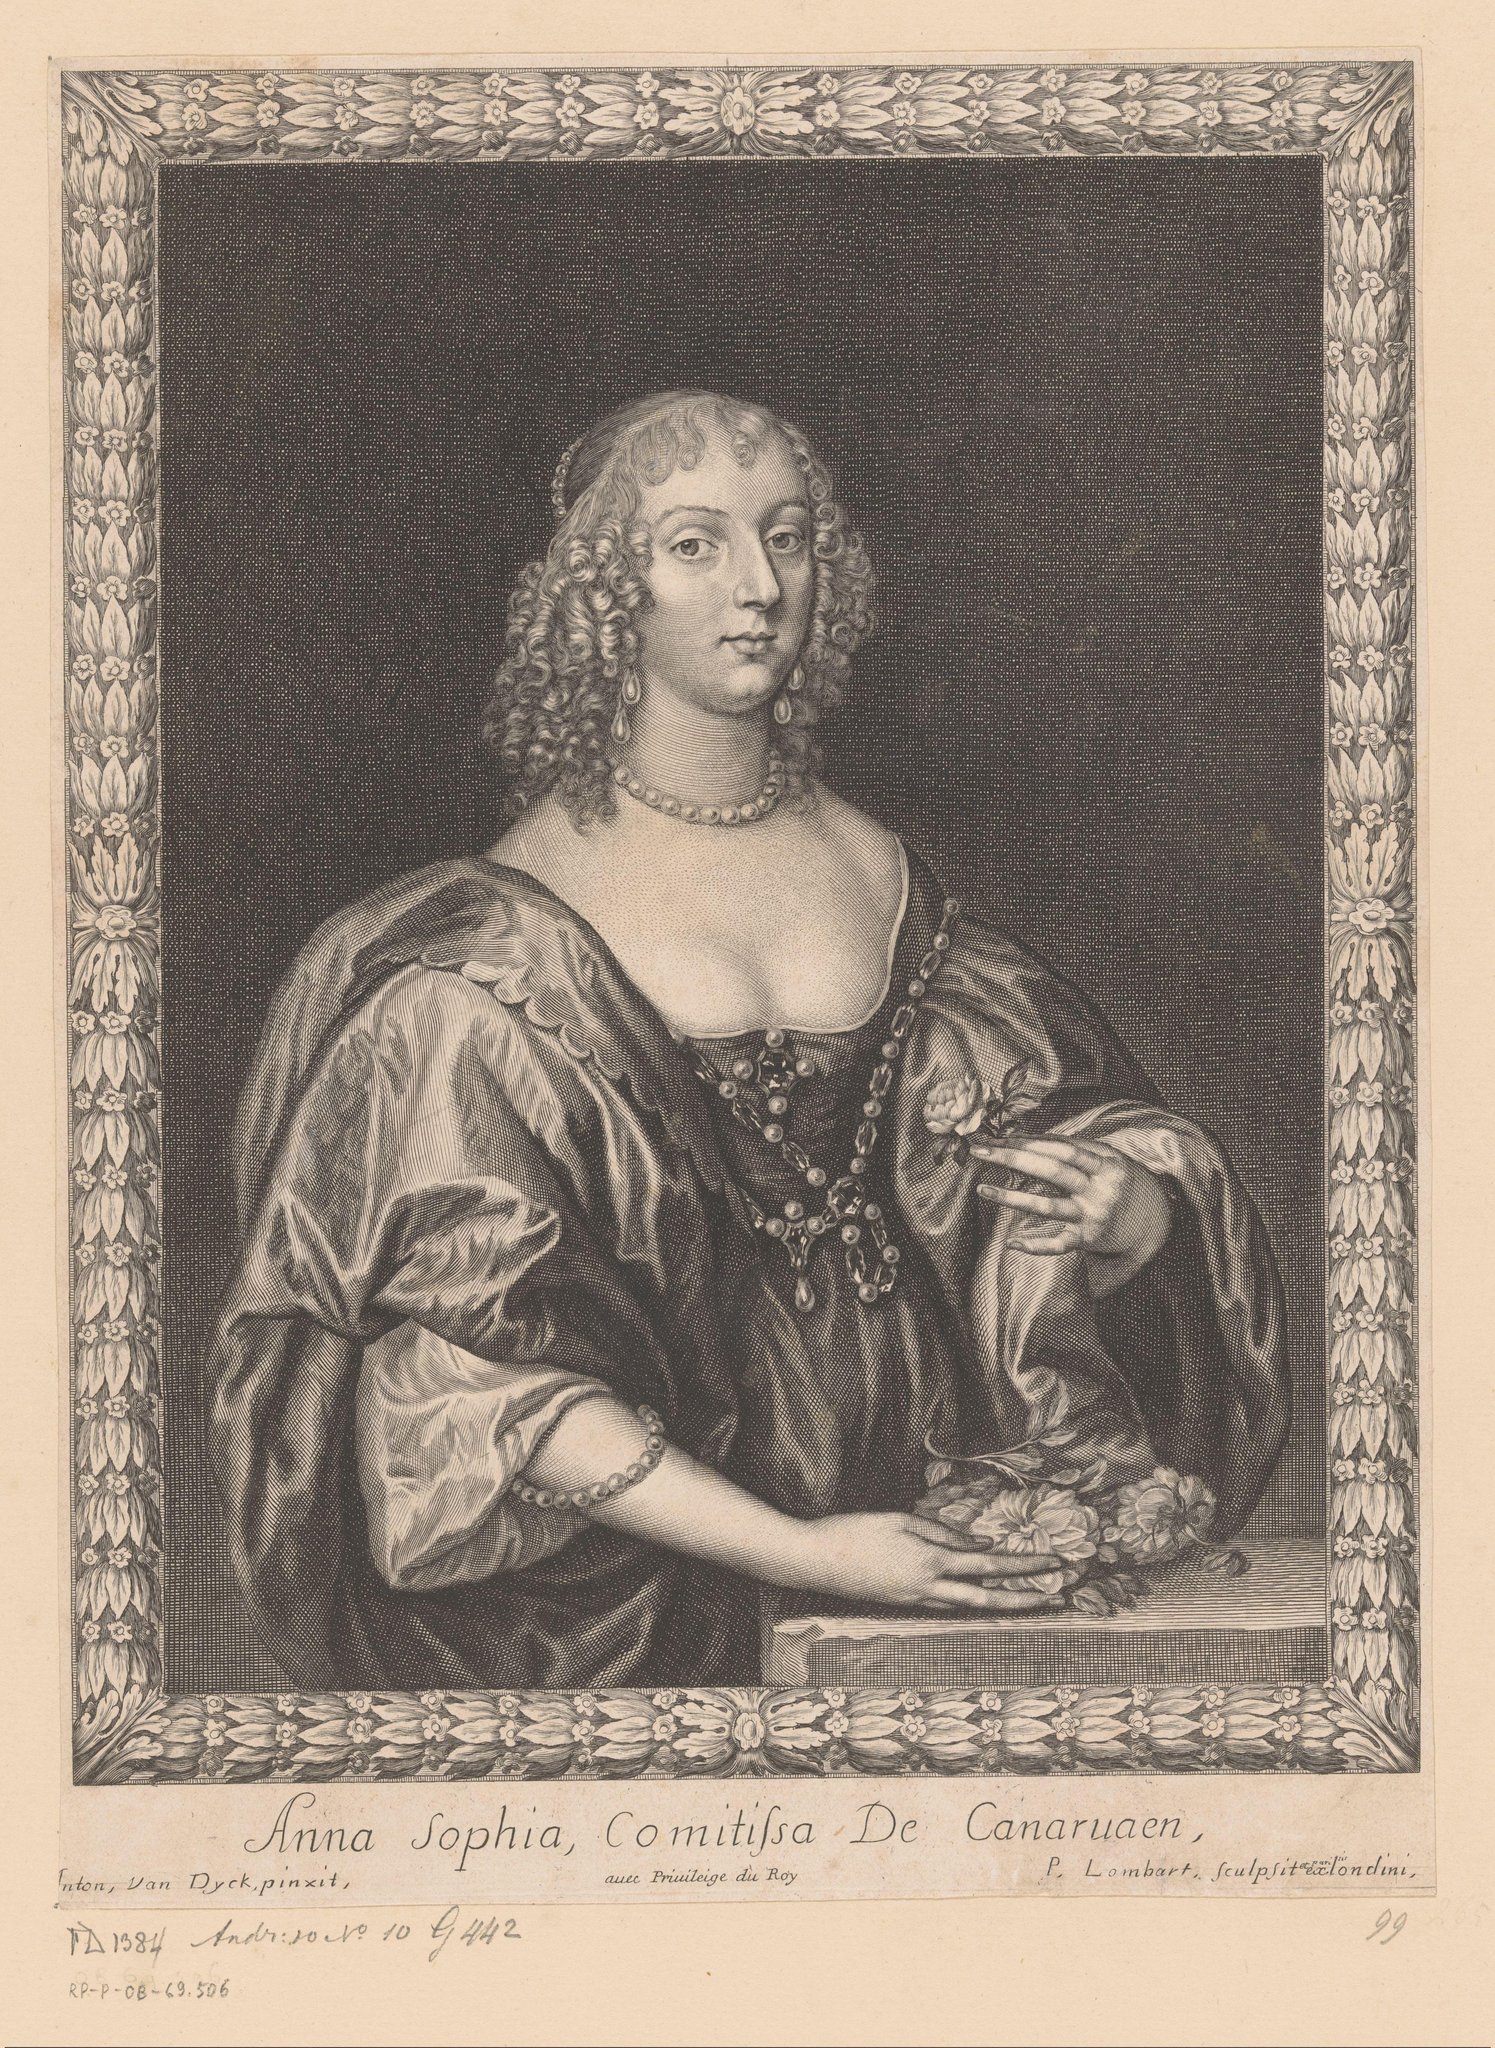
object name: print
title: Portretten van graven en gravinnen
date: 1660-1663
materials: paper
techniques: engraving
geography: paris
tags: historical persons - bb - woman, frame of painting, etc., nobility and patriciate; chivalry, knighthood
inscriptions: collector's mark: Lugt 240